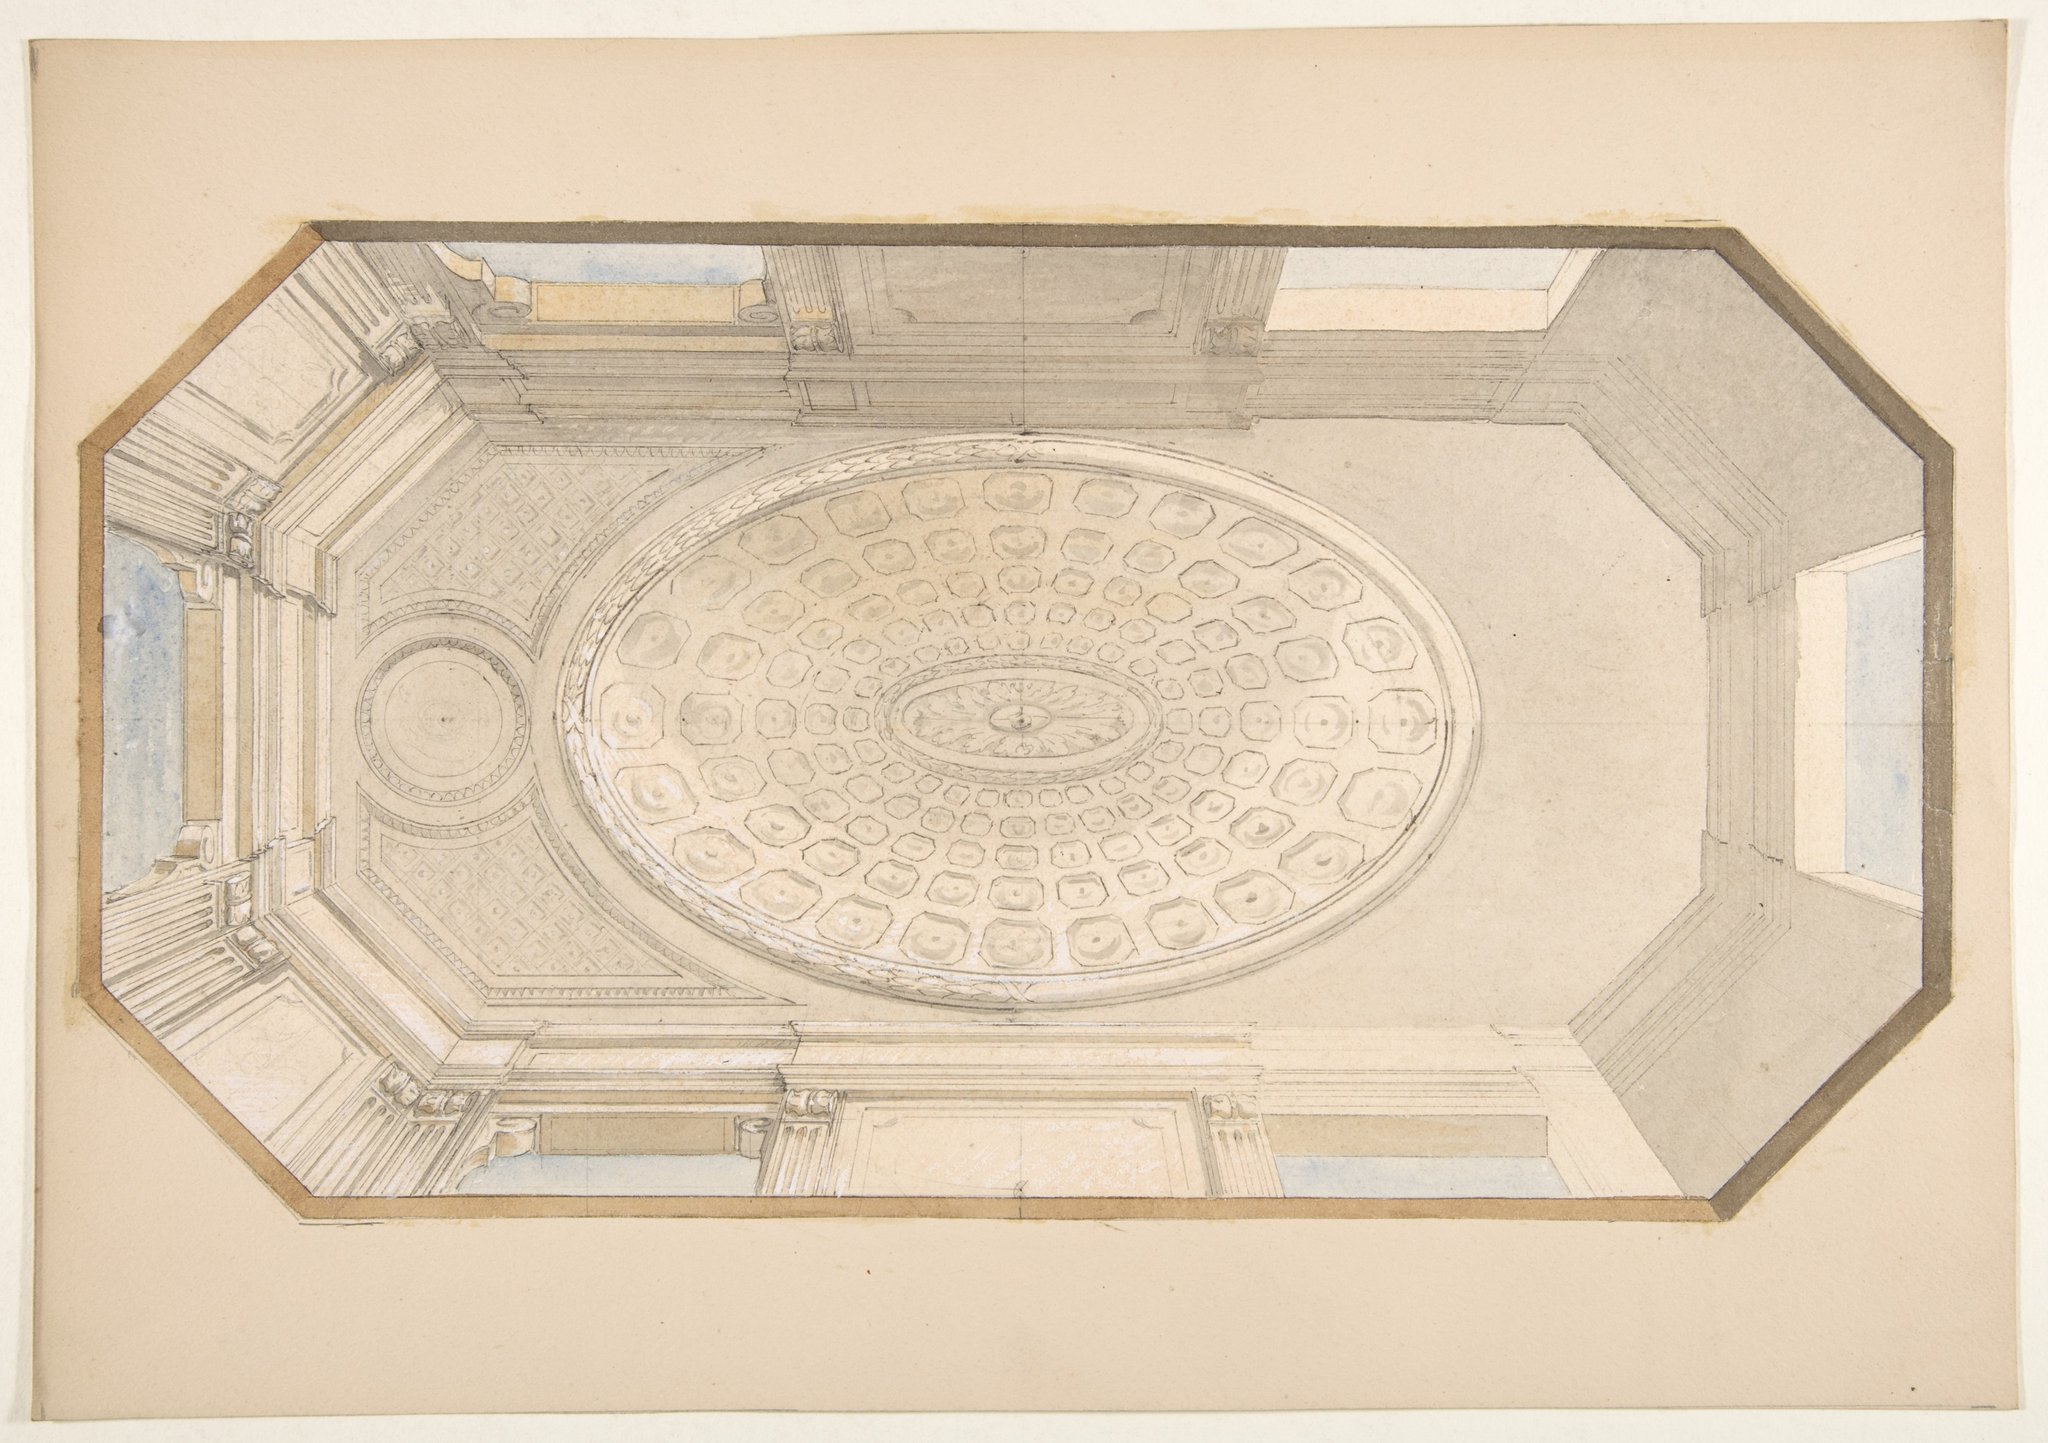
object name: drawing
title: Design for a coiffered ceiling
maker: jules-edmond-charles lachaise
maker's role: artist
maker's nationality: french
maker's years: 1897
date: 1851-1900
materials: gouache, graphite, ink, watercolor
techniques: pen